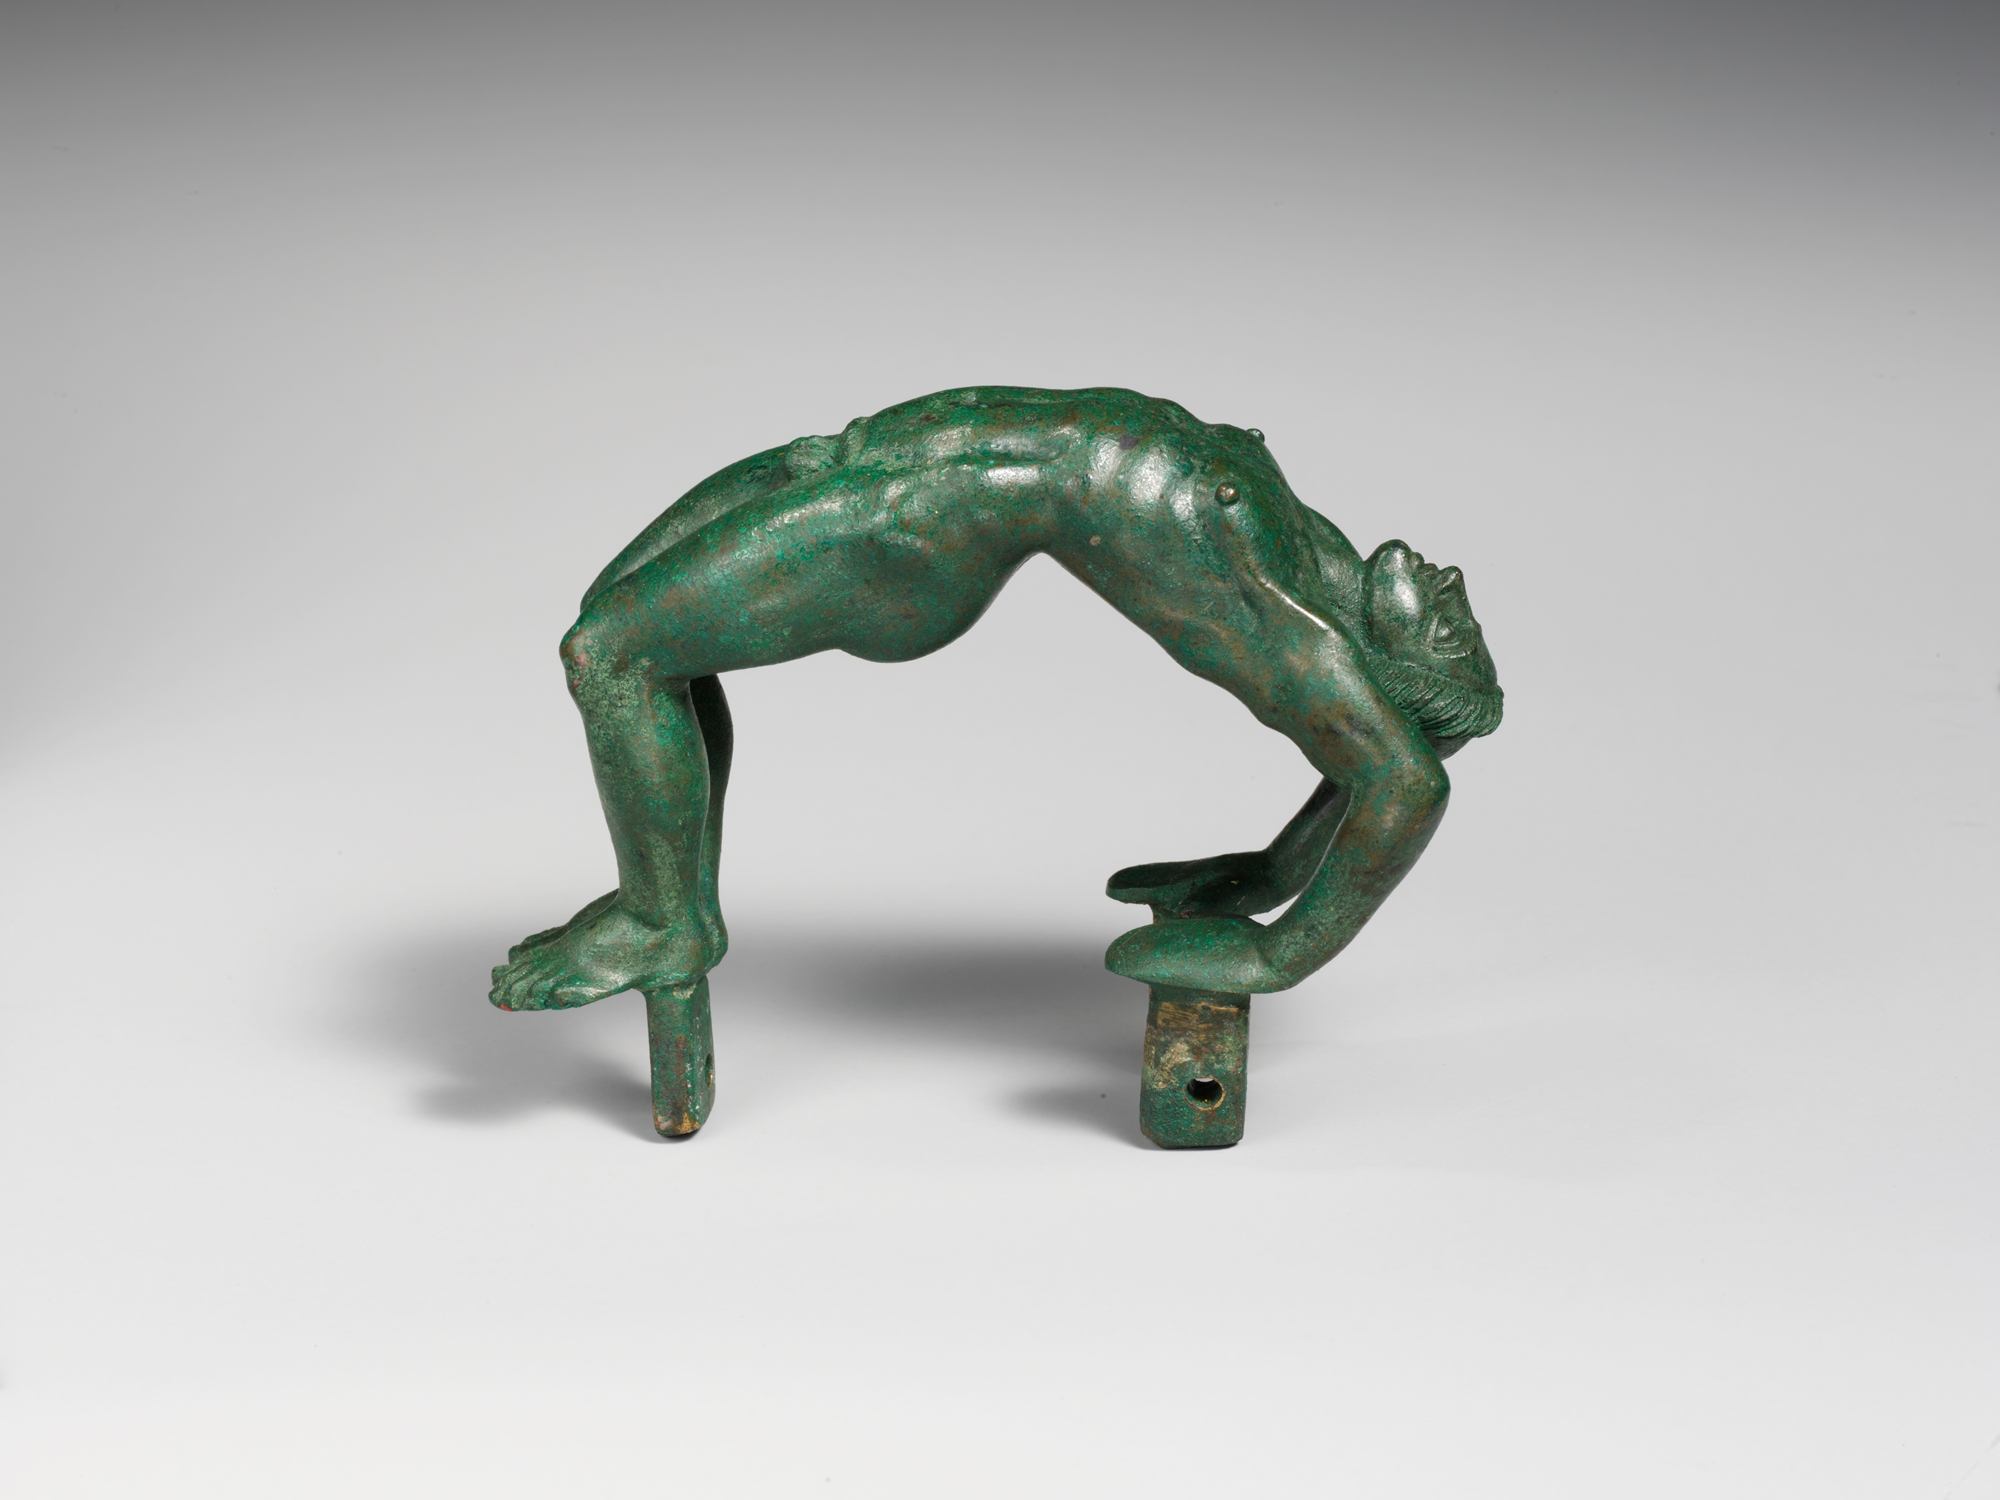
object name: handle of a cista, acrobat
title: Bronze handle from a cista (toiletries box)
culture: praenestine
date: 400-301 BCE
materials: bronze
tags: male nudes